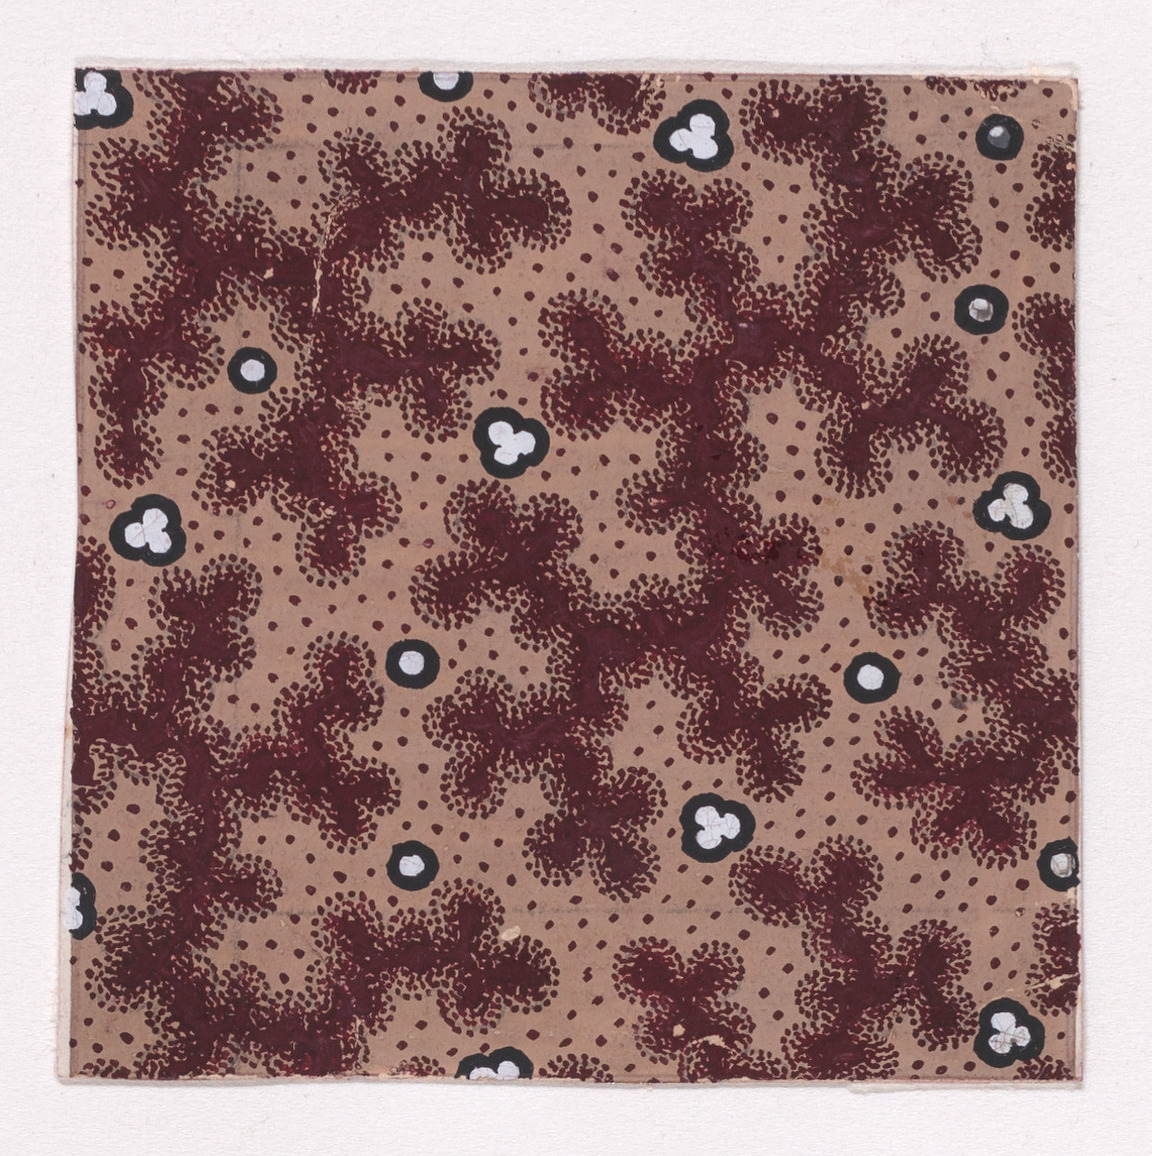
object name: drawing ornament architecture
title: Textile Design with Abstract Bundles of Stylized Leaves and Pearls Over Dotted Background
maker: anonymous, alsatian, 19th century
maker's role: artist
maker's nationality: alsatian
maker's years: 1800-1900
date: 1840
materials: gouache